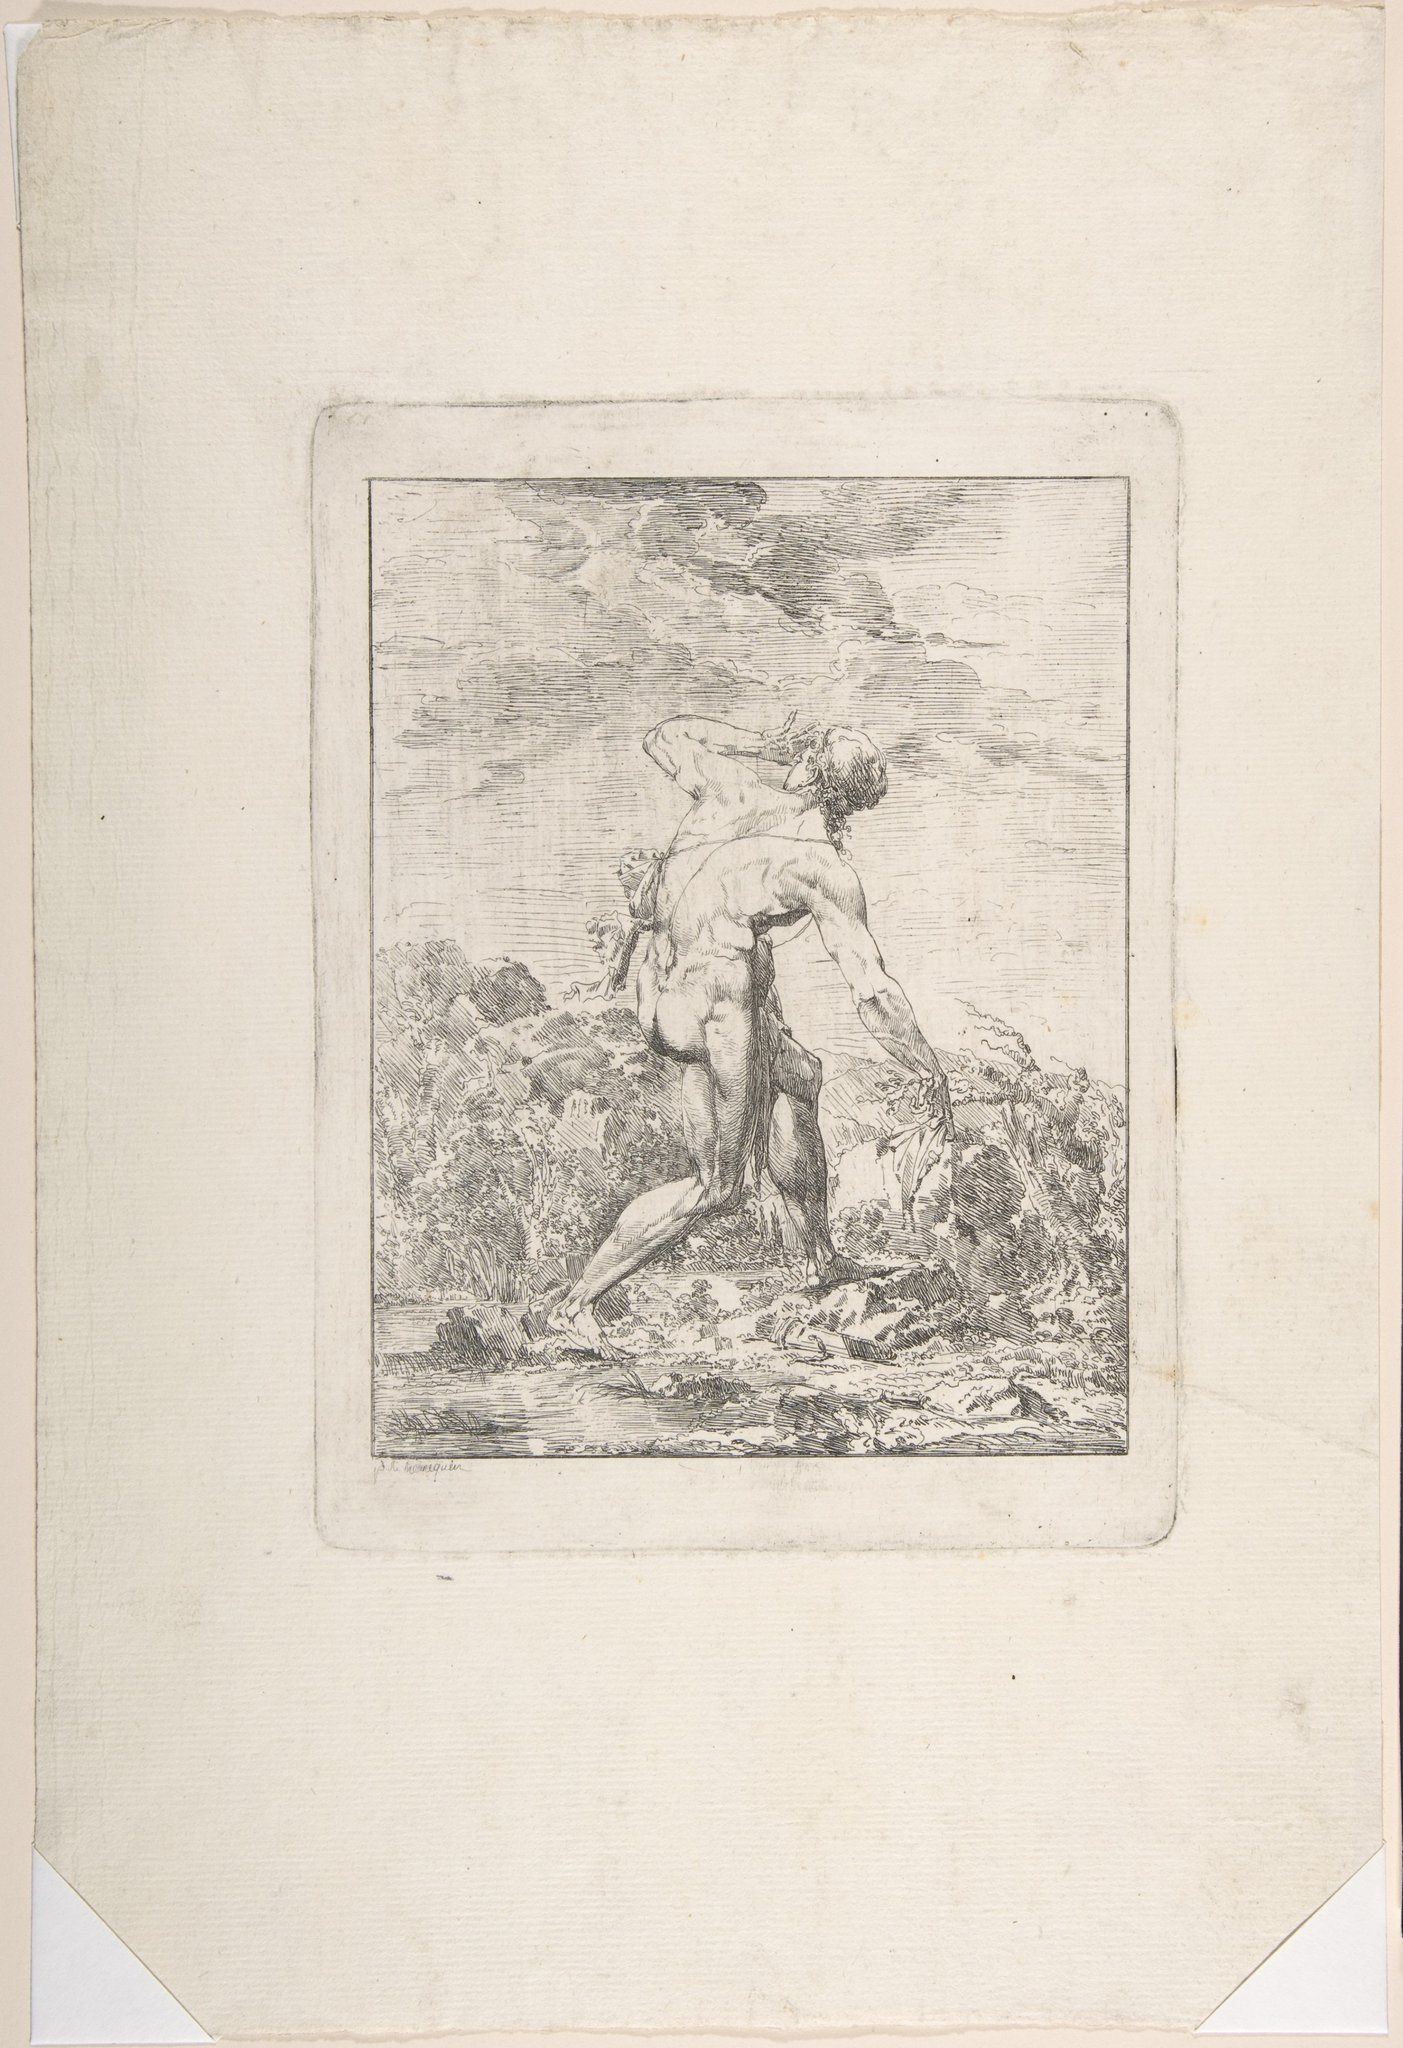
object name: print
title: Milo of Croton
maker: philippe auguste hennequin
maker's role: artist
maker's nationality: french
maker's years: 1762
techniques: etching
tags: male nudes,landscapes